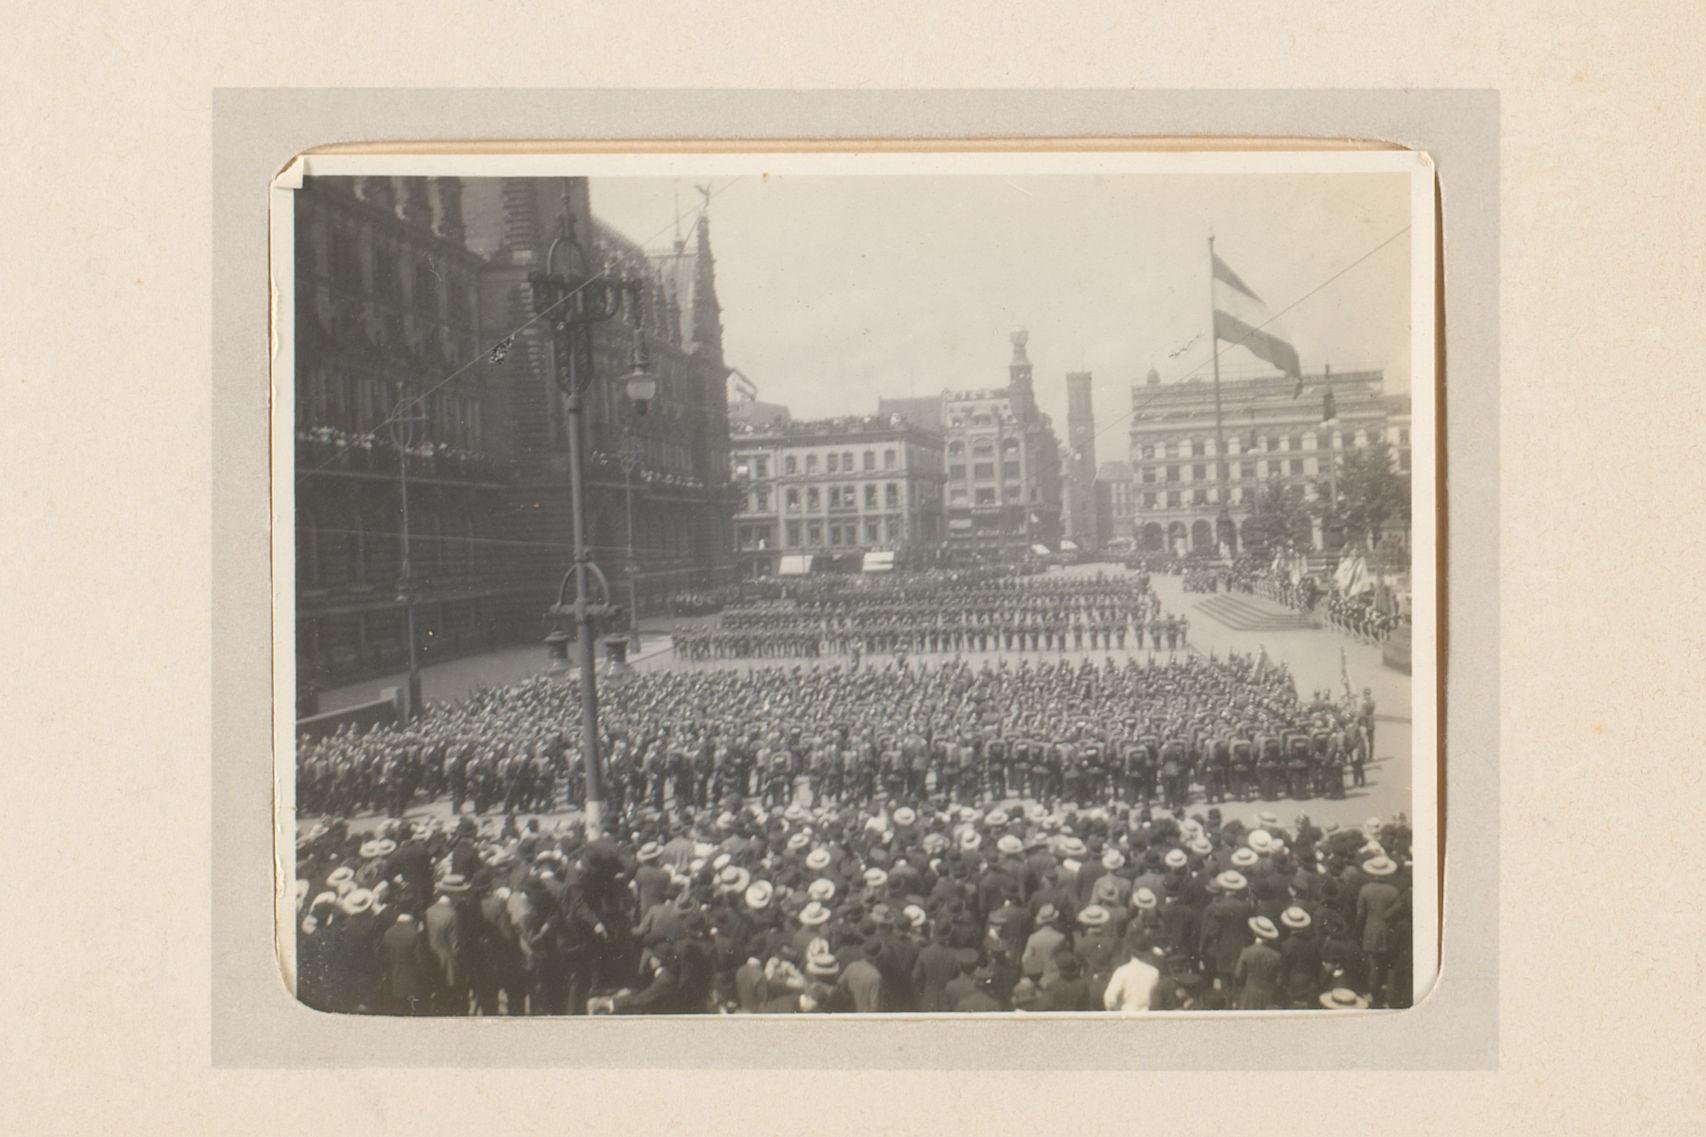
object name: album leaf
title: Militaire parade op een plein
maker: liesbeth overhoff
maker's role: fotograaf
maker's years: 1895-1969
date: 1911-1912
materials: paper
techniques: gelatin silver print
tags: square, place, circus, etc., flag display, military parade, pageant